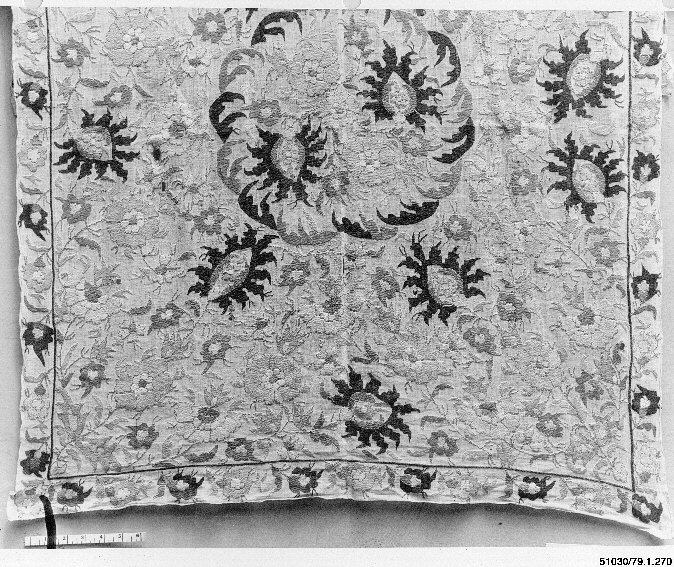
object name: cover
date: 1801-1833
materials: linen, silk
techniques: embroidery, weave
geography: turkey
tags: flowers